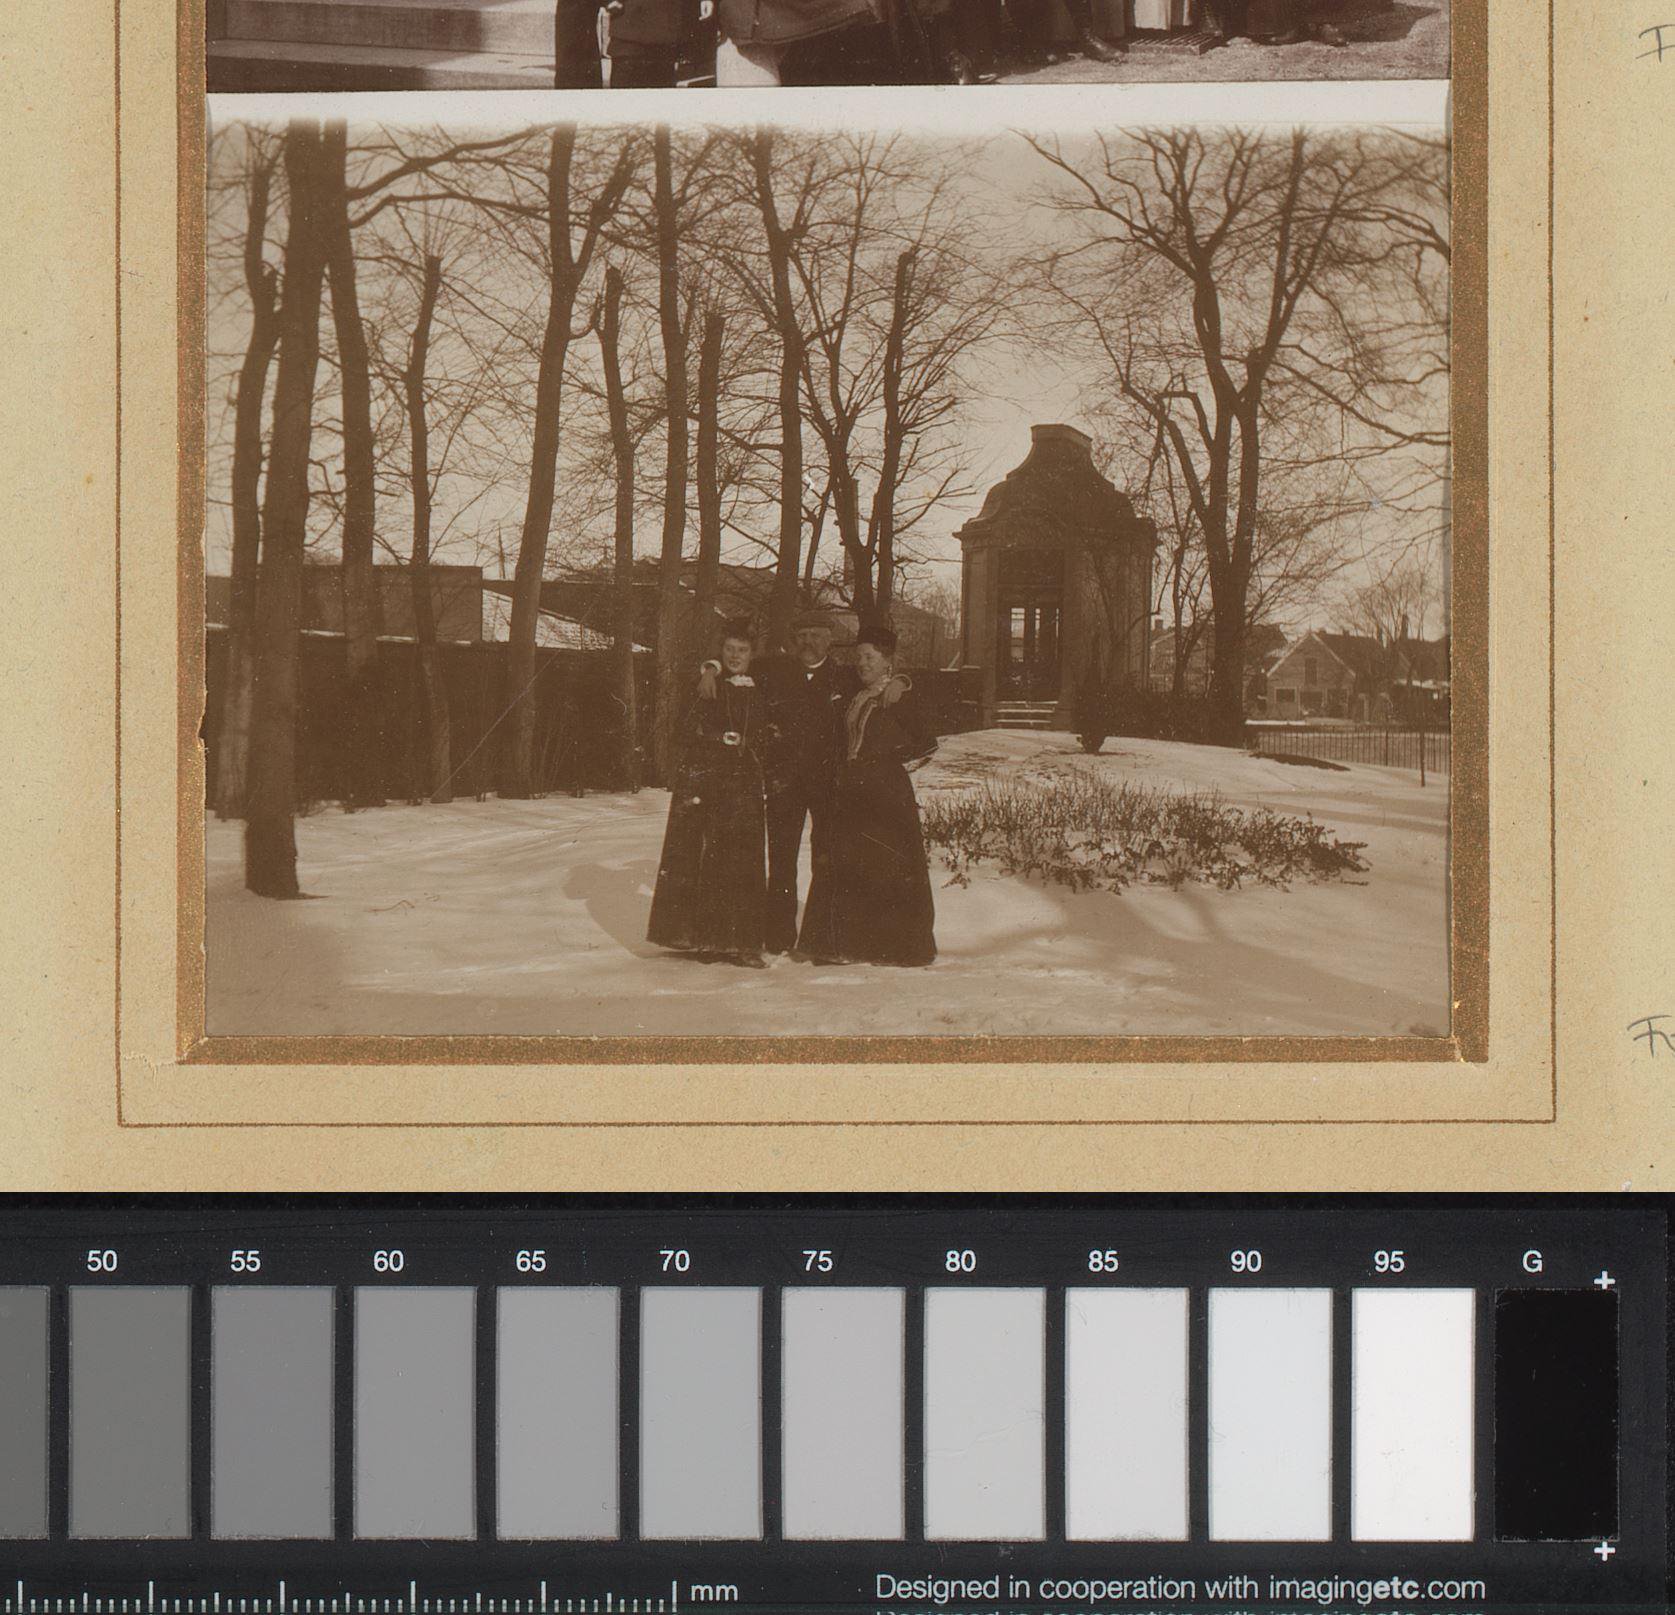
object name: photograph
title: Man en twee vrouwen staand in de sneeuw bij prieel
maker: Anonymous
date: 1890-1920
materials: photographic support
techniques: collodion silver print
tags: winter landscape; landscape symbolizing winter (the four seasons of the year), anonymous historical persons portrayed in a group, in a group-portrait